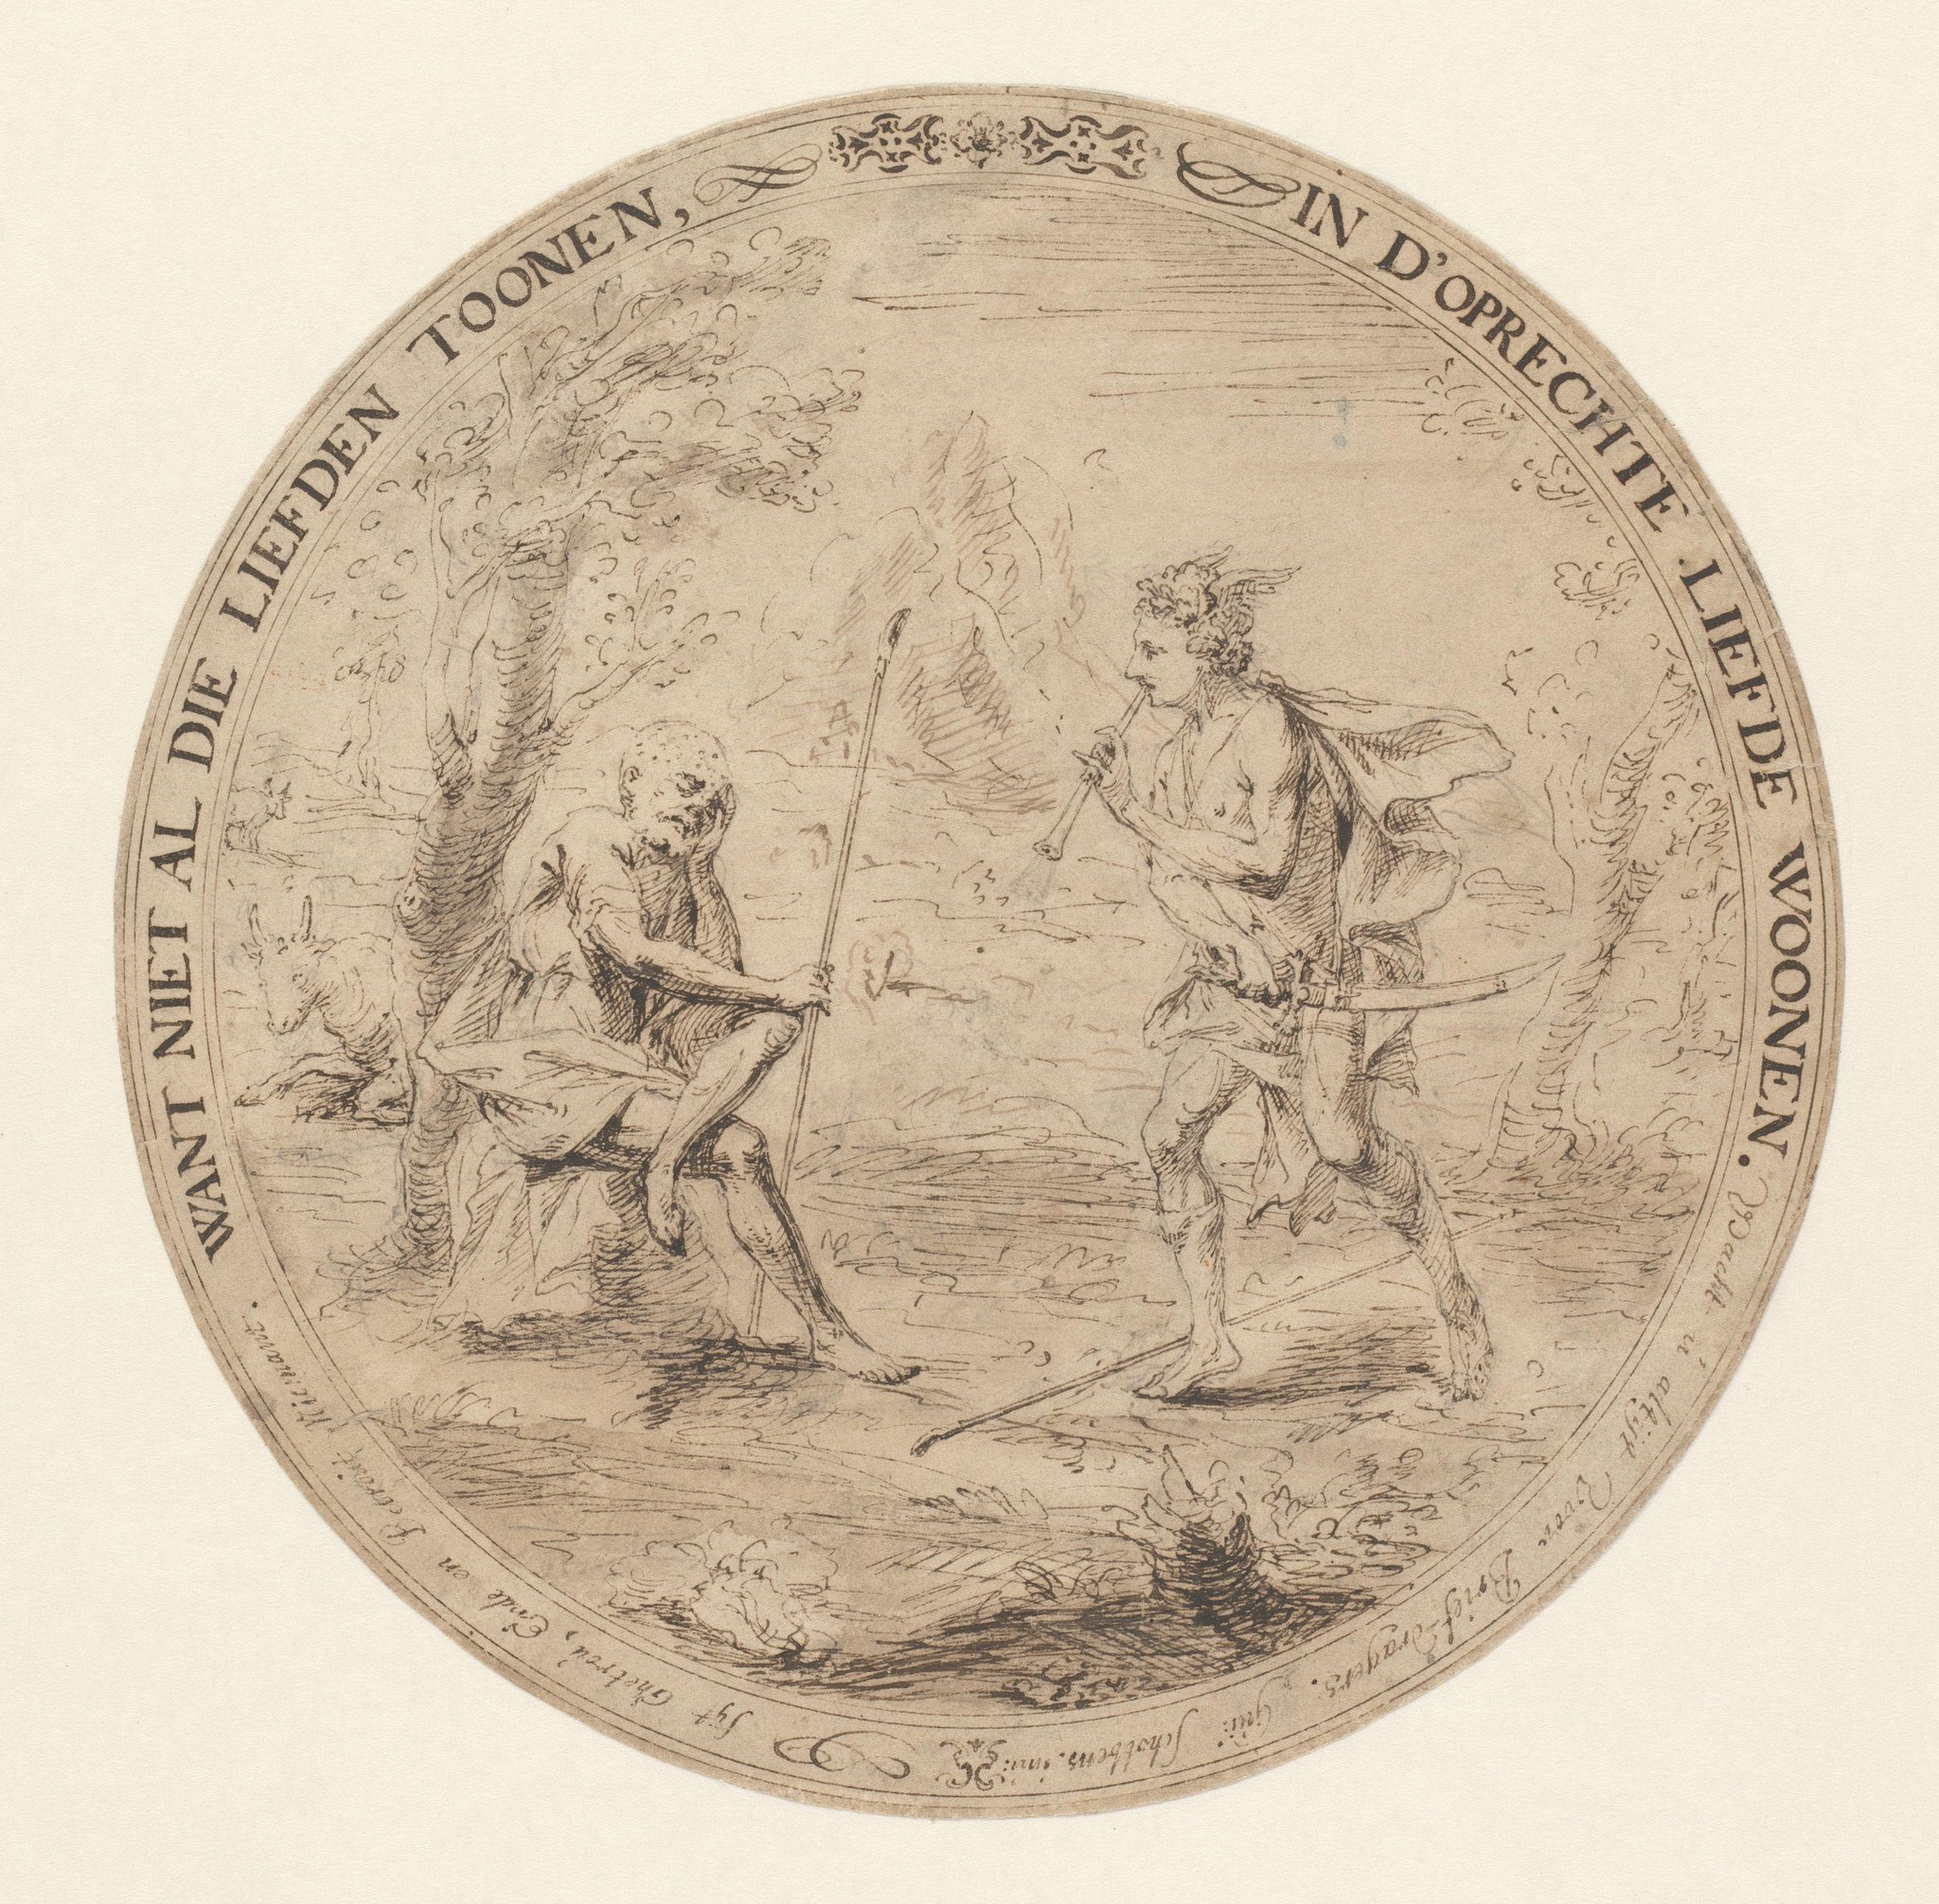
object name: drawing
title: Mercurius doet Argus in slaap vallen met zijn fluitspel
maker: quellinus schobbens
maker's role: draughtsman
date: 1682-1711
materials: ink, paper, pencil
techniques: brush, pen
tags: mercury lulls argus into sleep by making music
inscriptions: : ‘Want niet al die liefden toonen, in d'oprechte liefde woonen.’